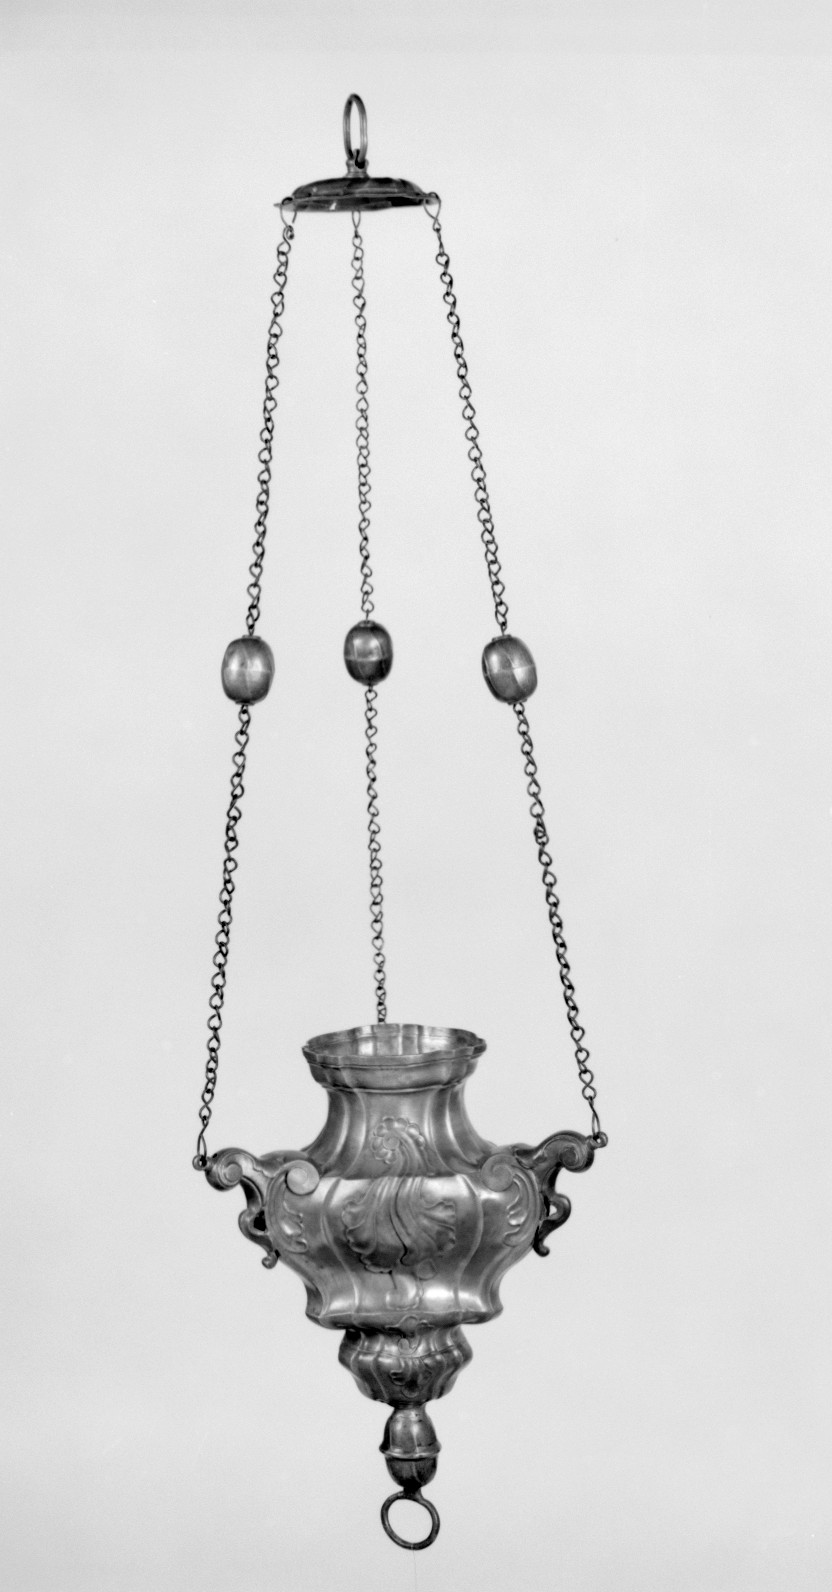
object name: chancel lamp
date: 1751-1800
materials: pewter